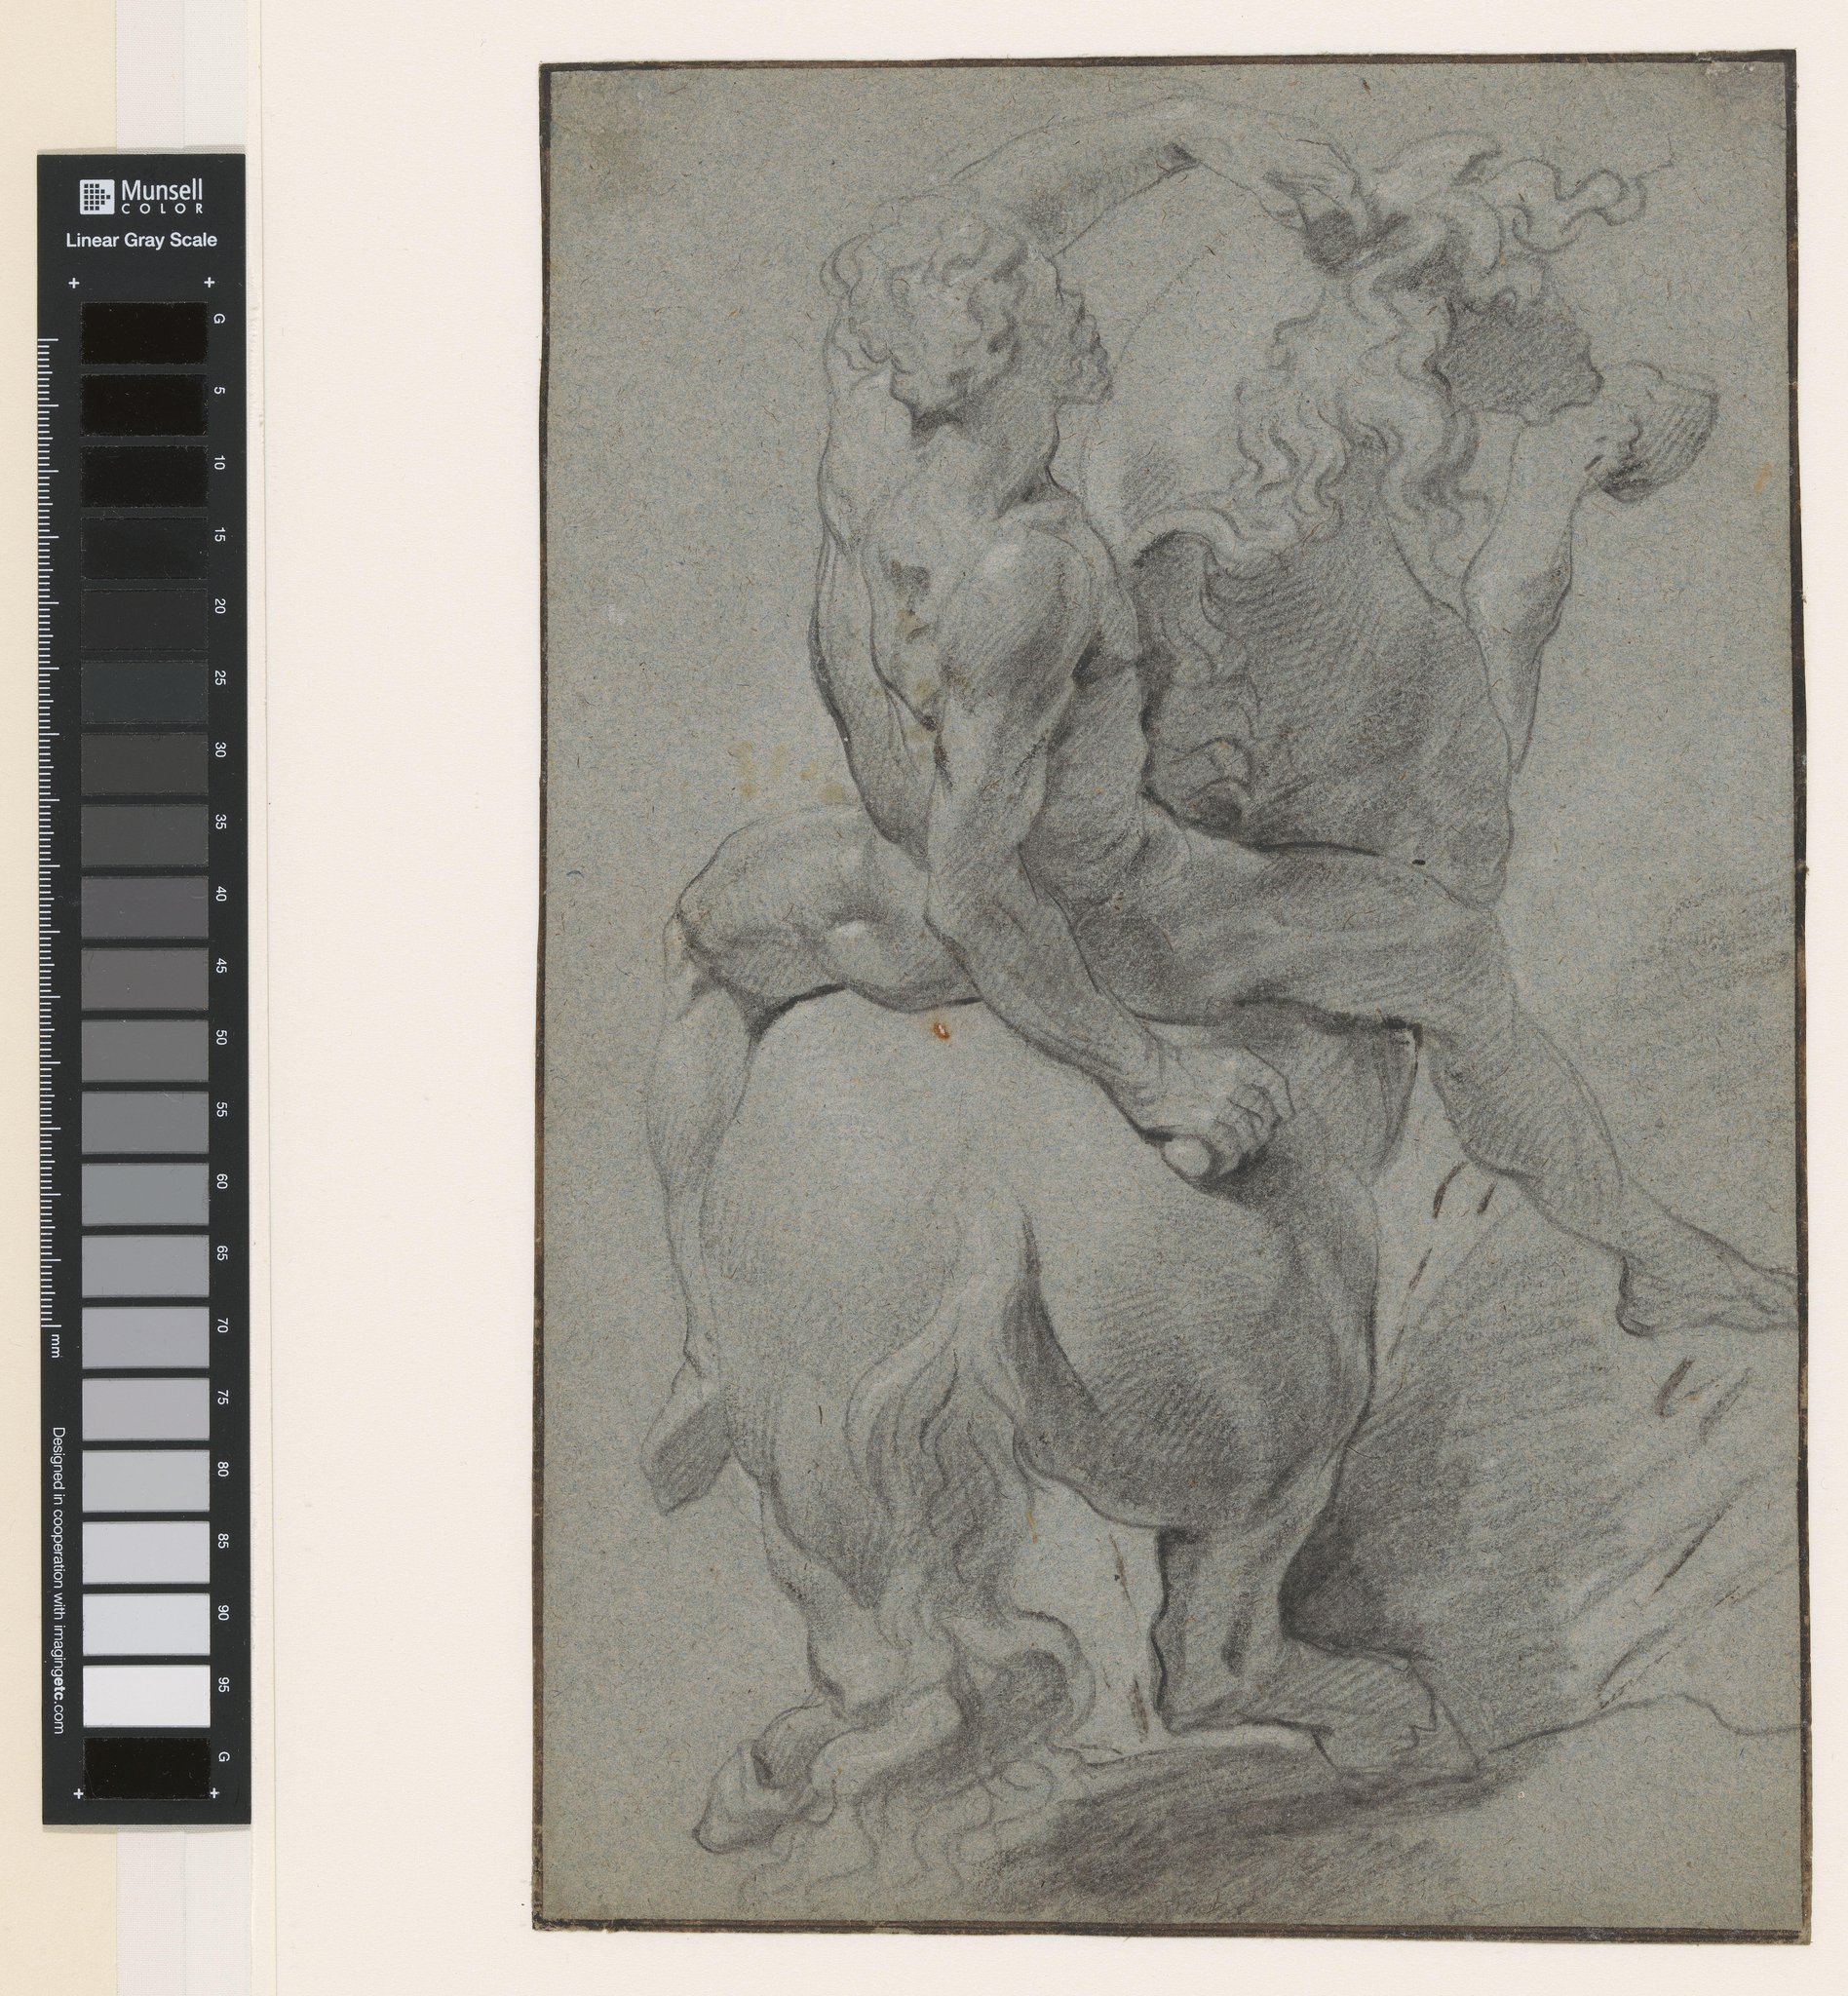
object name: drawing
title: Naakte ruiter op een steigerend paard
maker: Anonymous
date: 1600-1699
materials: chalk, paper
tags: riding a horse, ass, or mule; rider, horseman, piece of sculpture, reproduction of a piece of sculpture